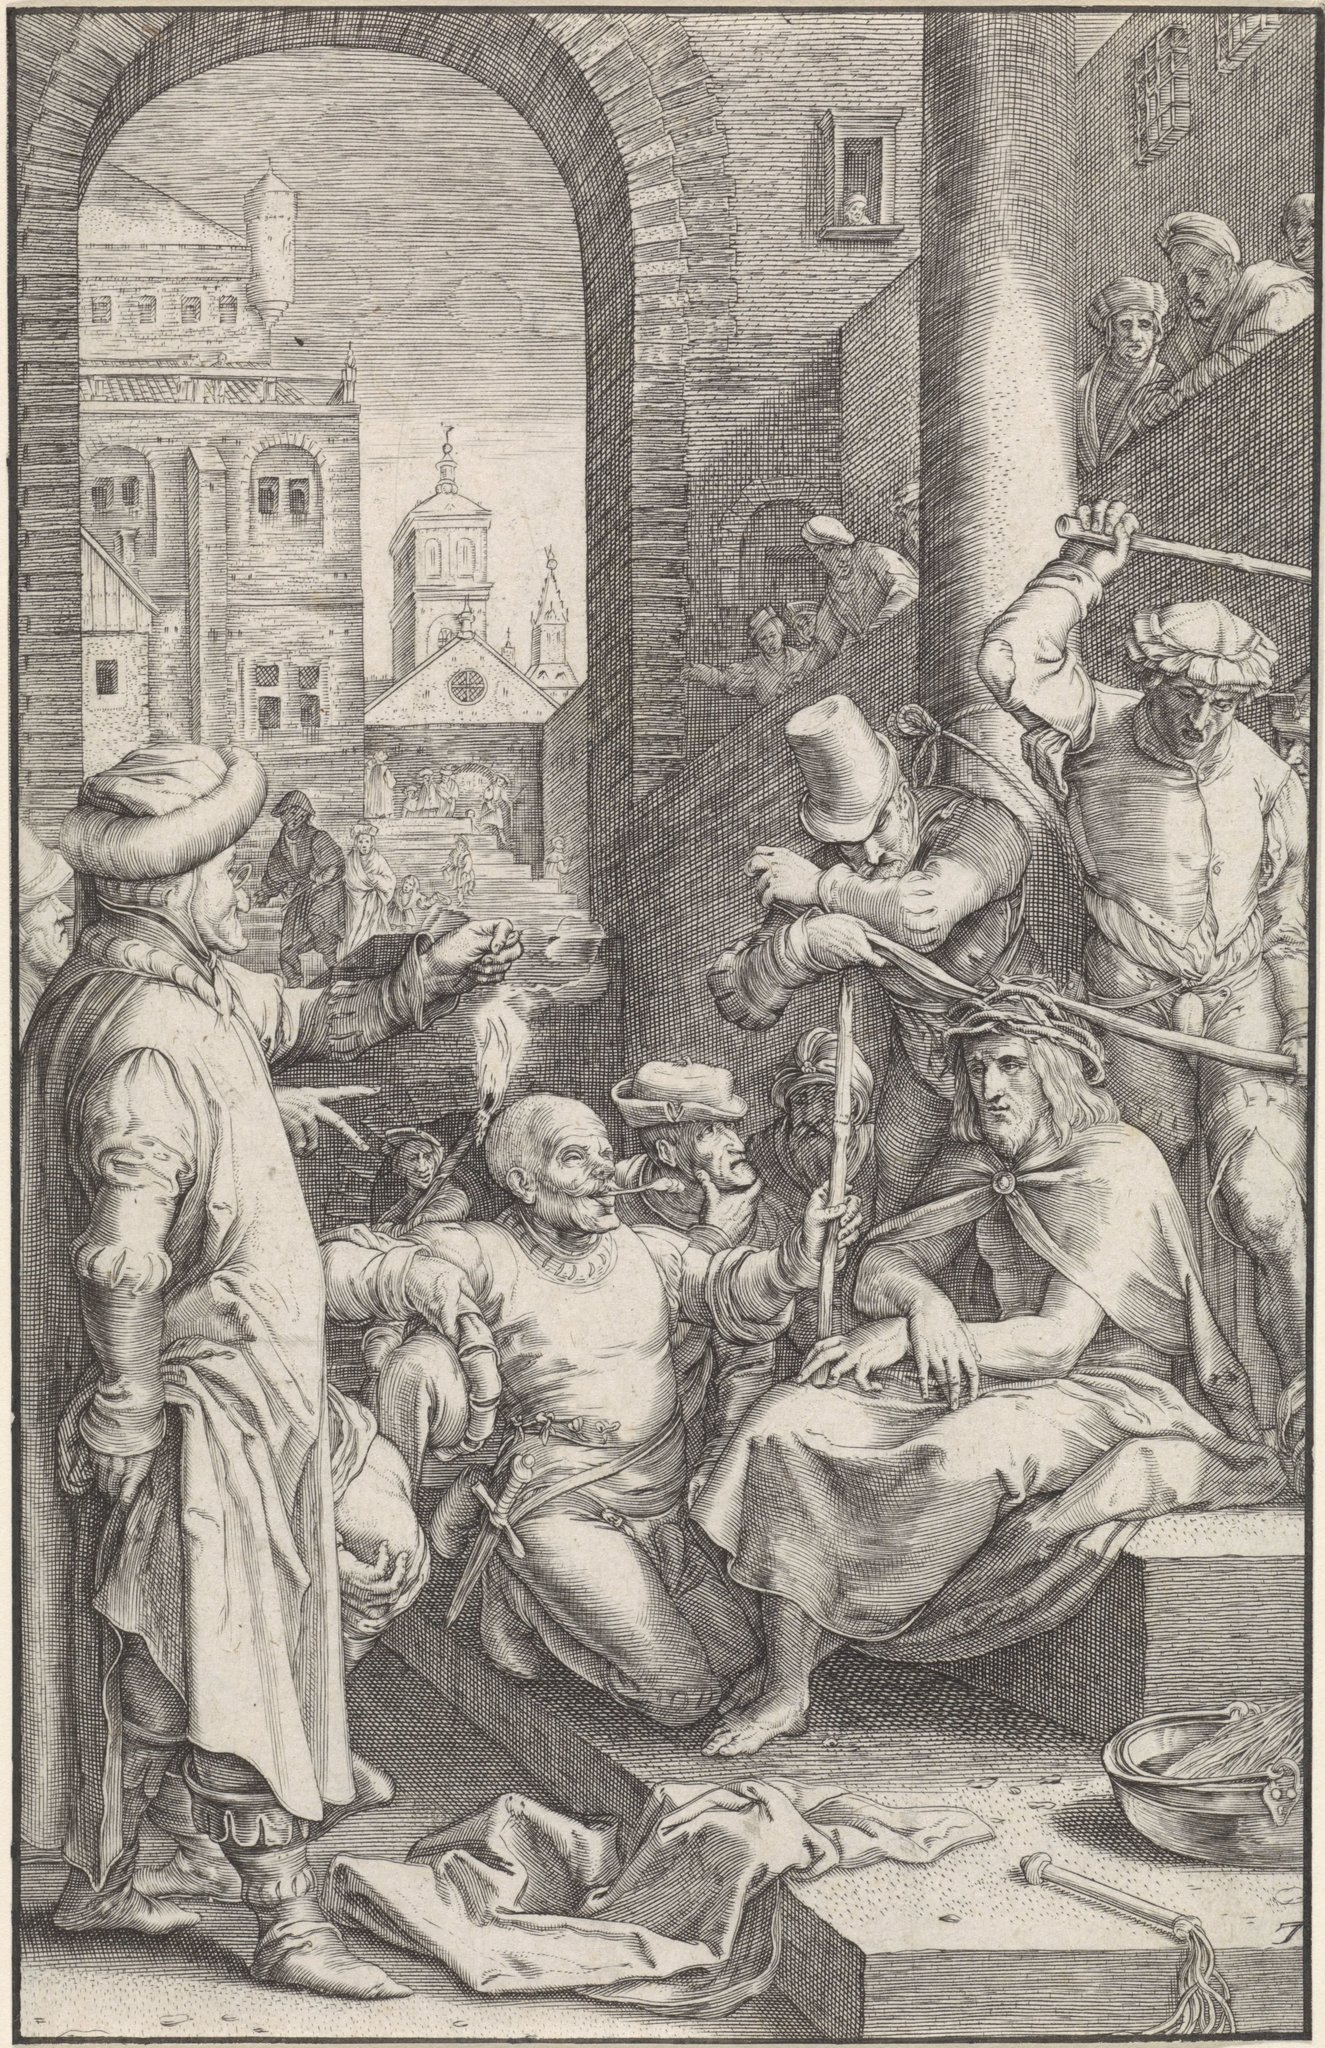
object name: print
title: Doornenkroning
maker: ludovicus siceram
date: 1623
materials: paper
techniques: engraving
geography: antwerp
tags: the crowning with thorns: soldiers with sticks place a thorny crown on christ's head and give him a reed (matthew 27:27-31; mark 15:16-20; john 19:2-3)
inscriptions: collector's mark: Lugt 2228a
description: Mannen duwen Christus een doornenkroon op het hoofd. Een man knielt voor hem en geeft hem een riet als staf.